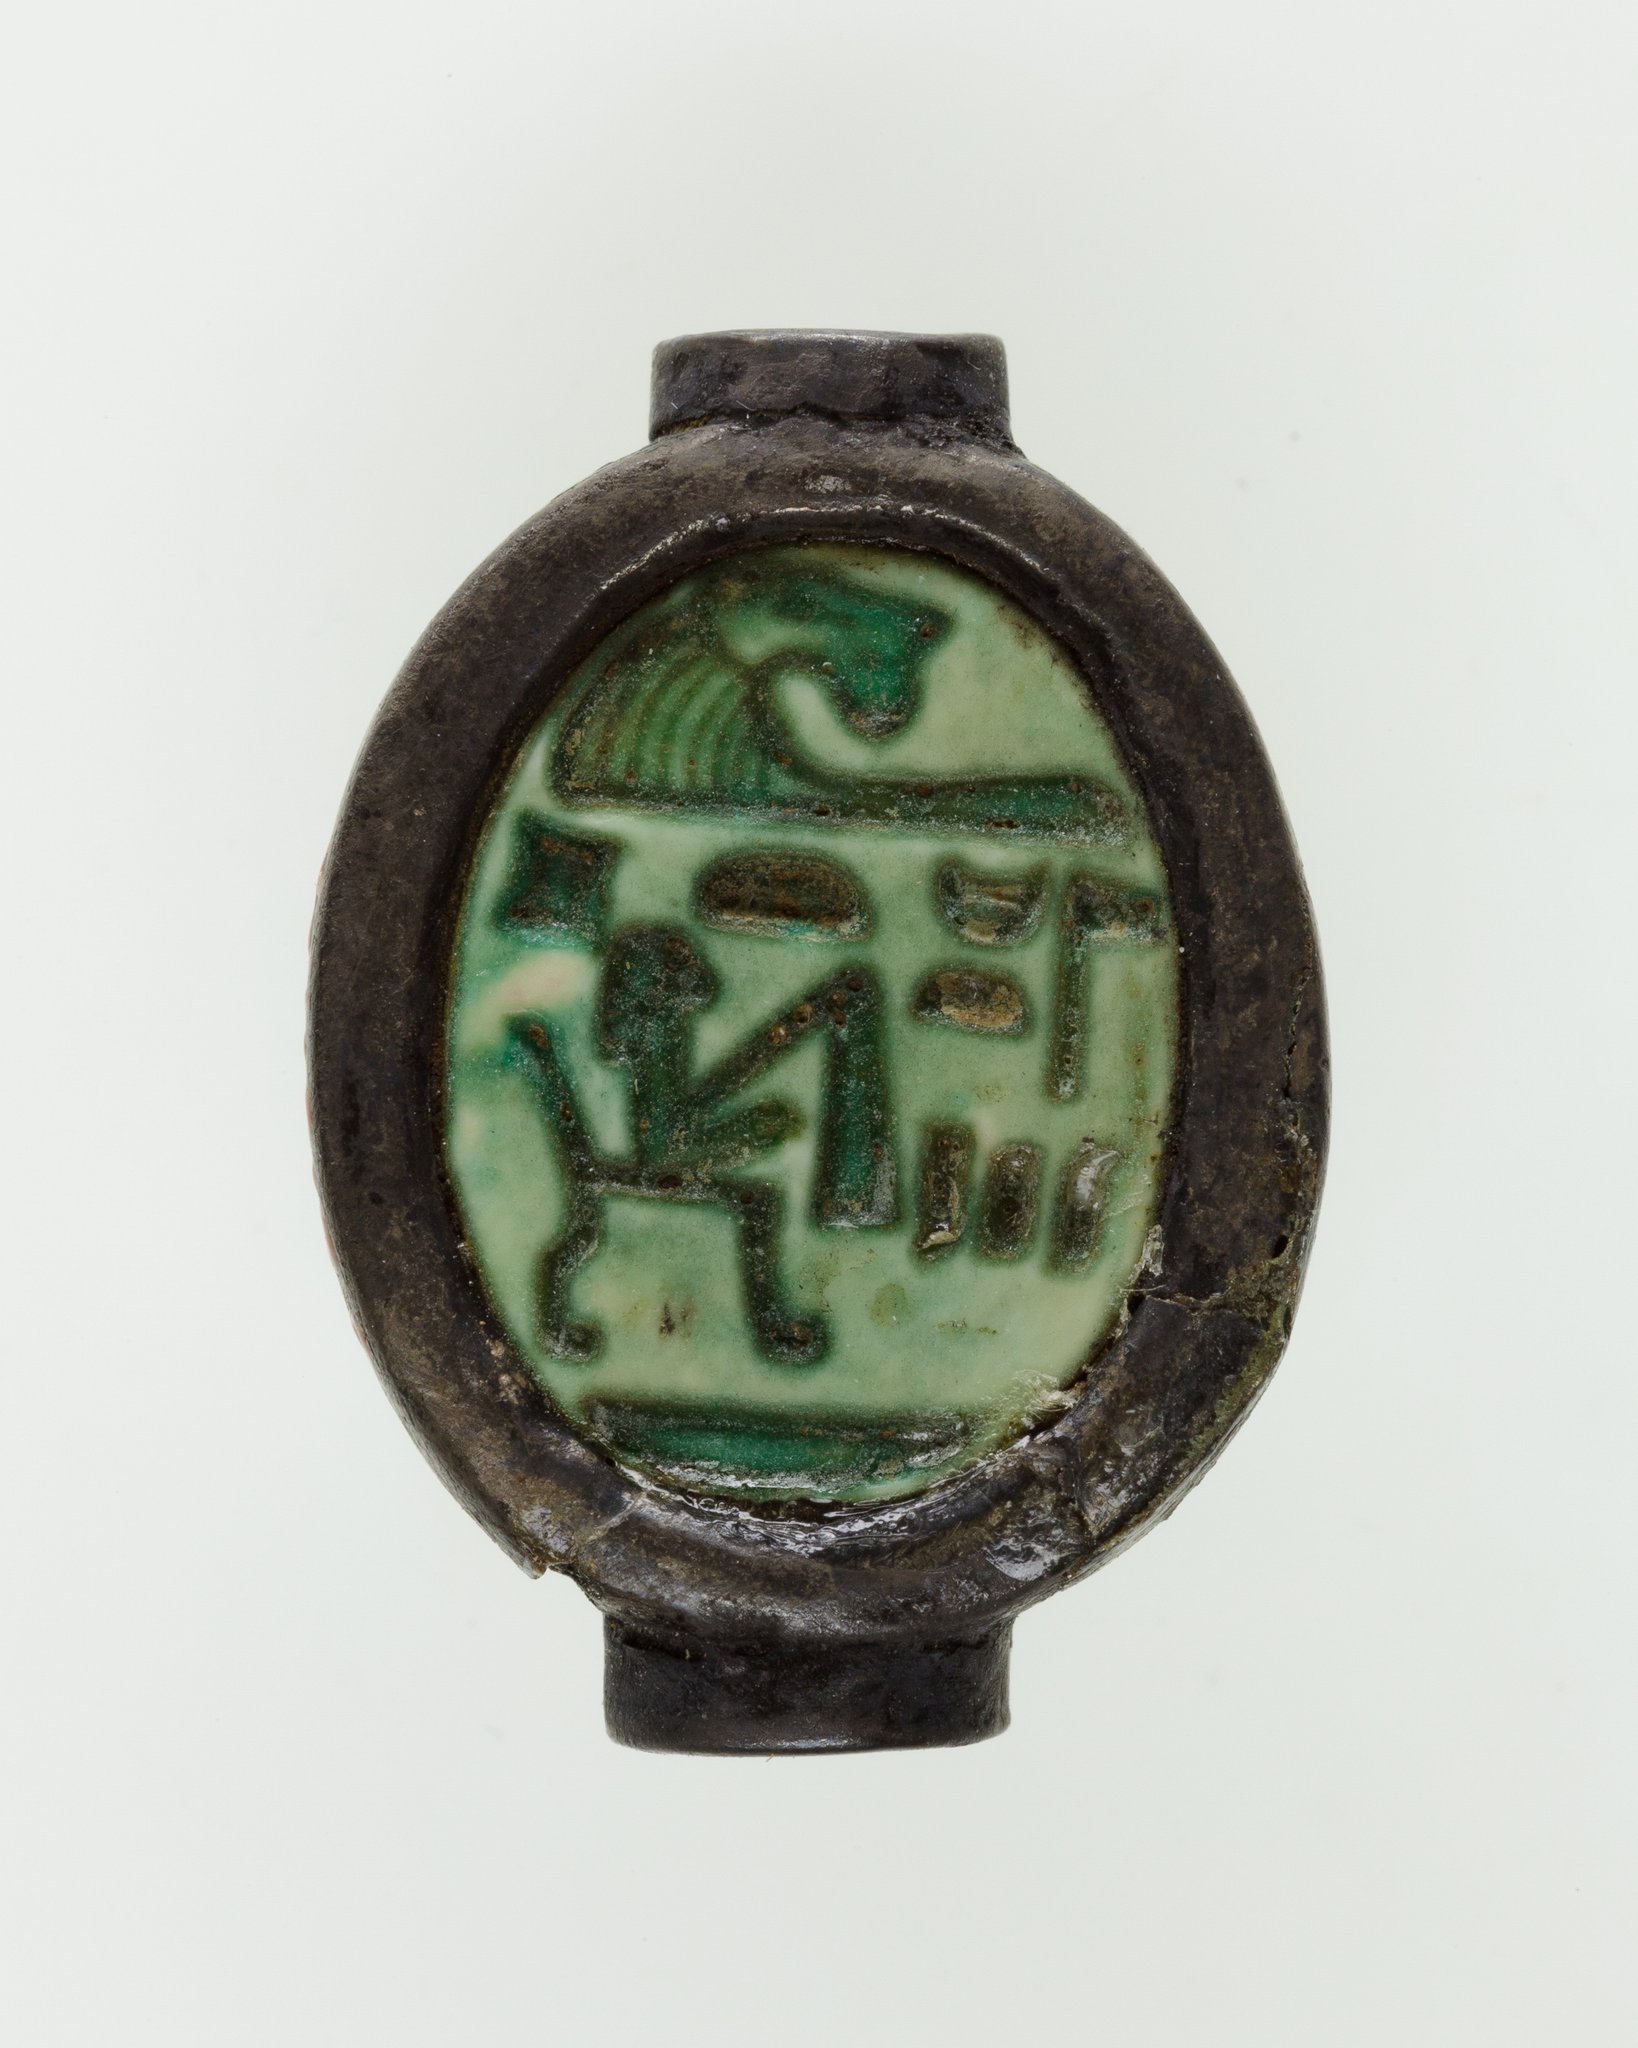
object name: scarab, ring bezel, hatshepsut, god's wife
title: Scarab Inscribed for the God's Wife Hatshepsut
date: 1492-1473 BCE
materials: silver, stone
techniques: glazing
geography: egypt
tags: scarabs